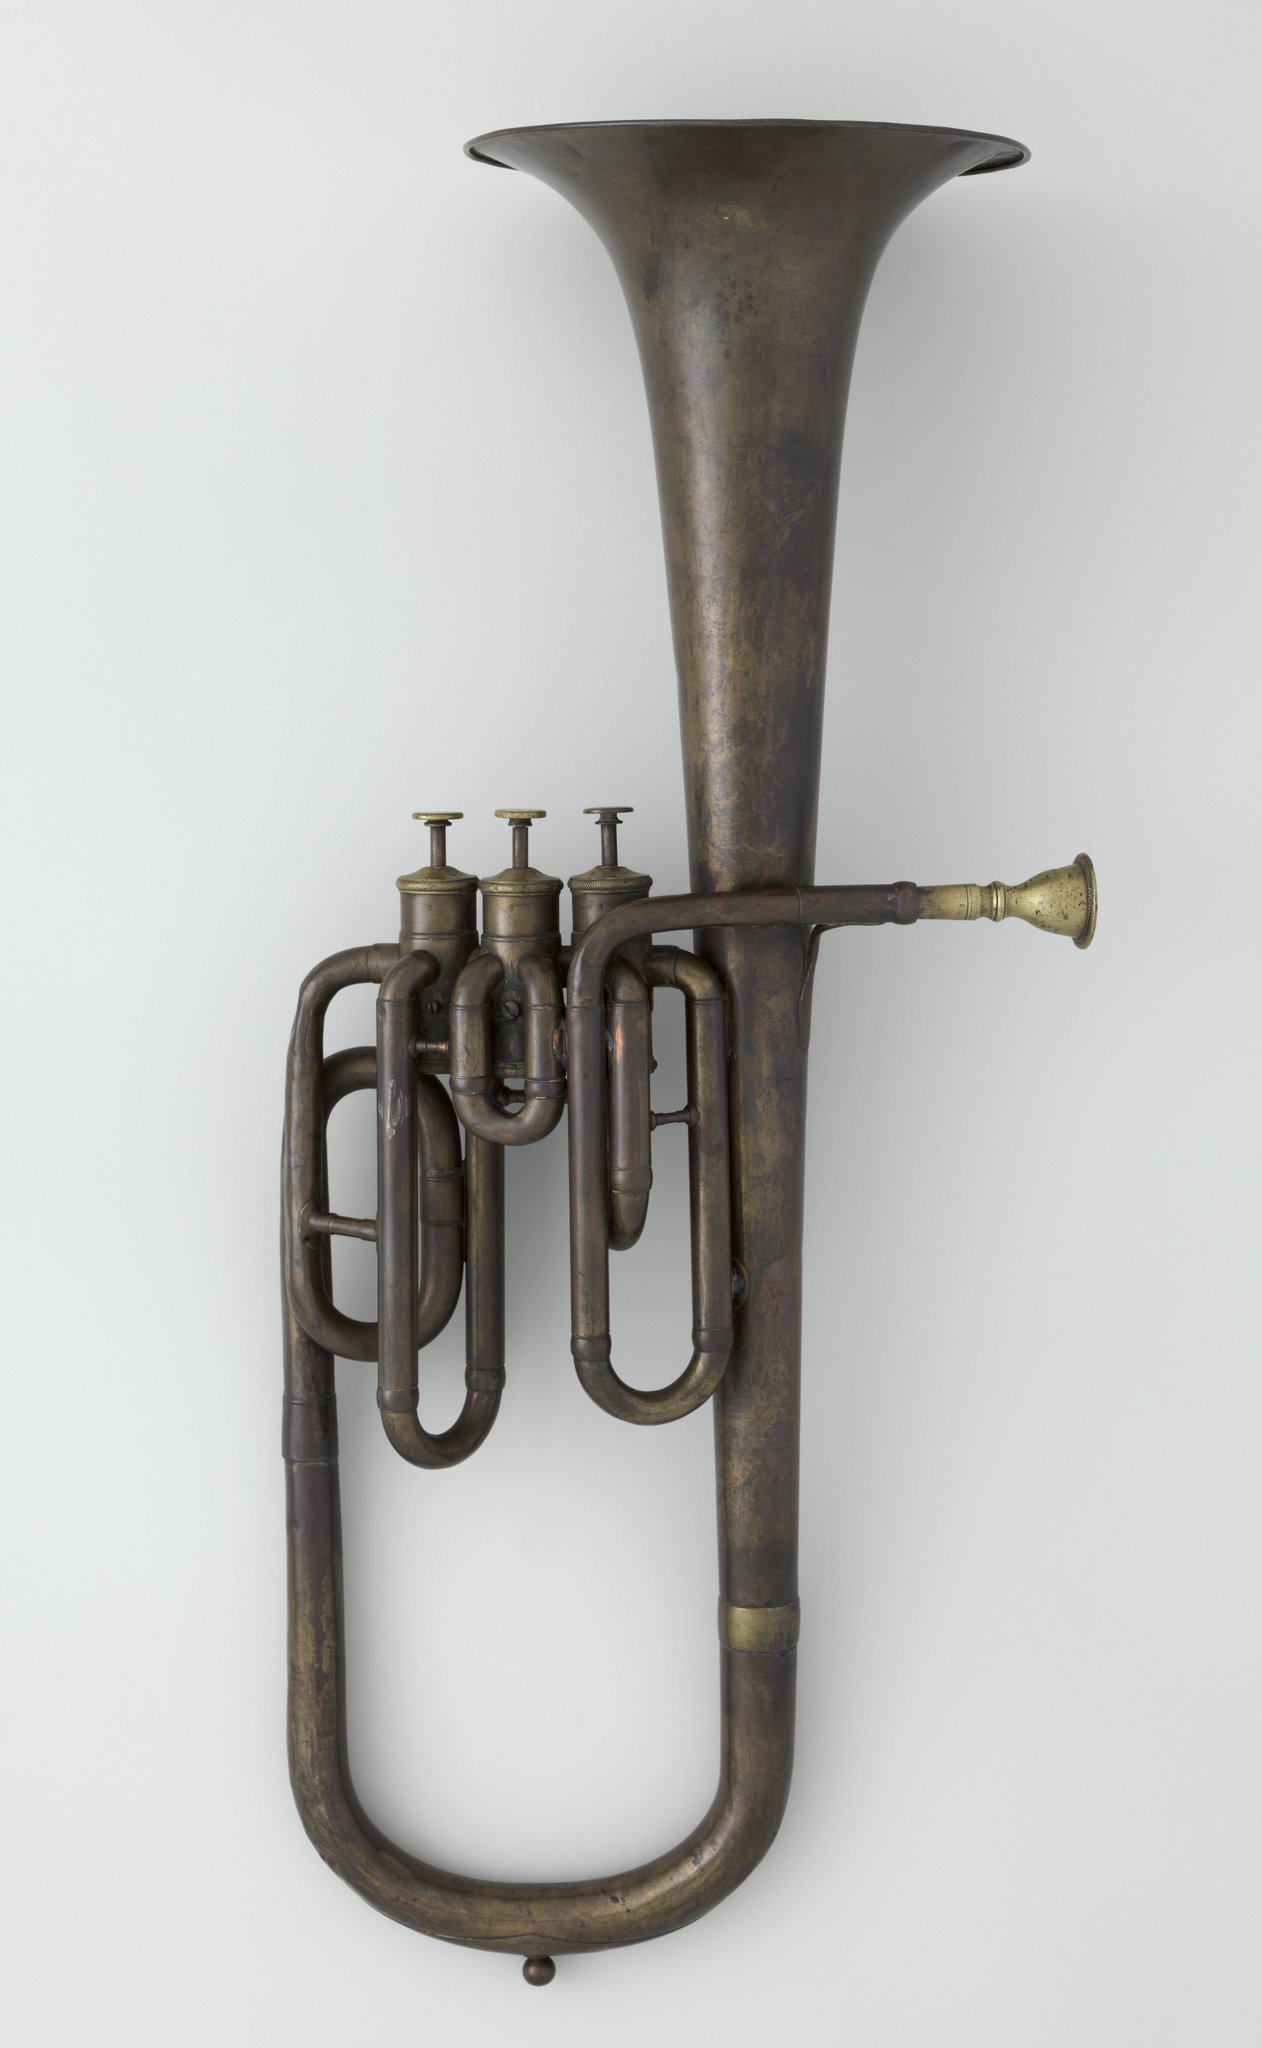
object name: alto saxhorn in e flat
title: Alto Saxhorn in E-flat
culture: french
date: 1850-1860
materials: brass, nickel, silver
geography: france